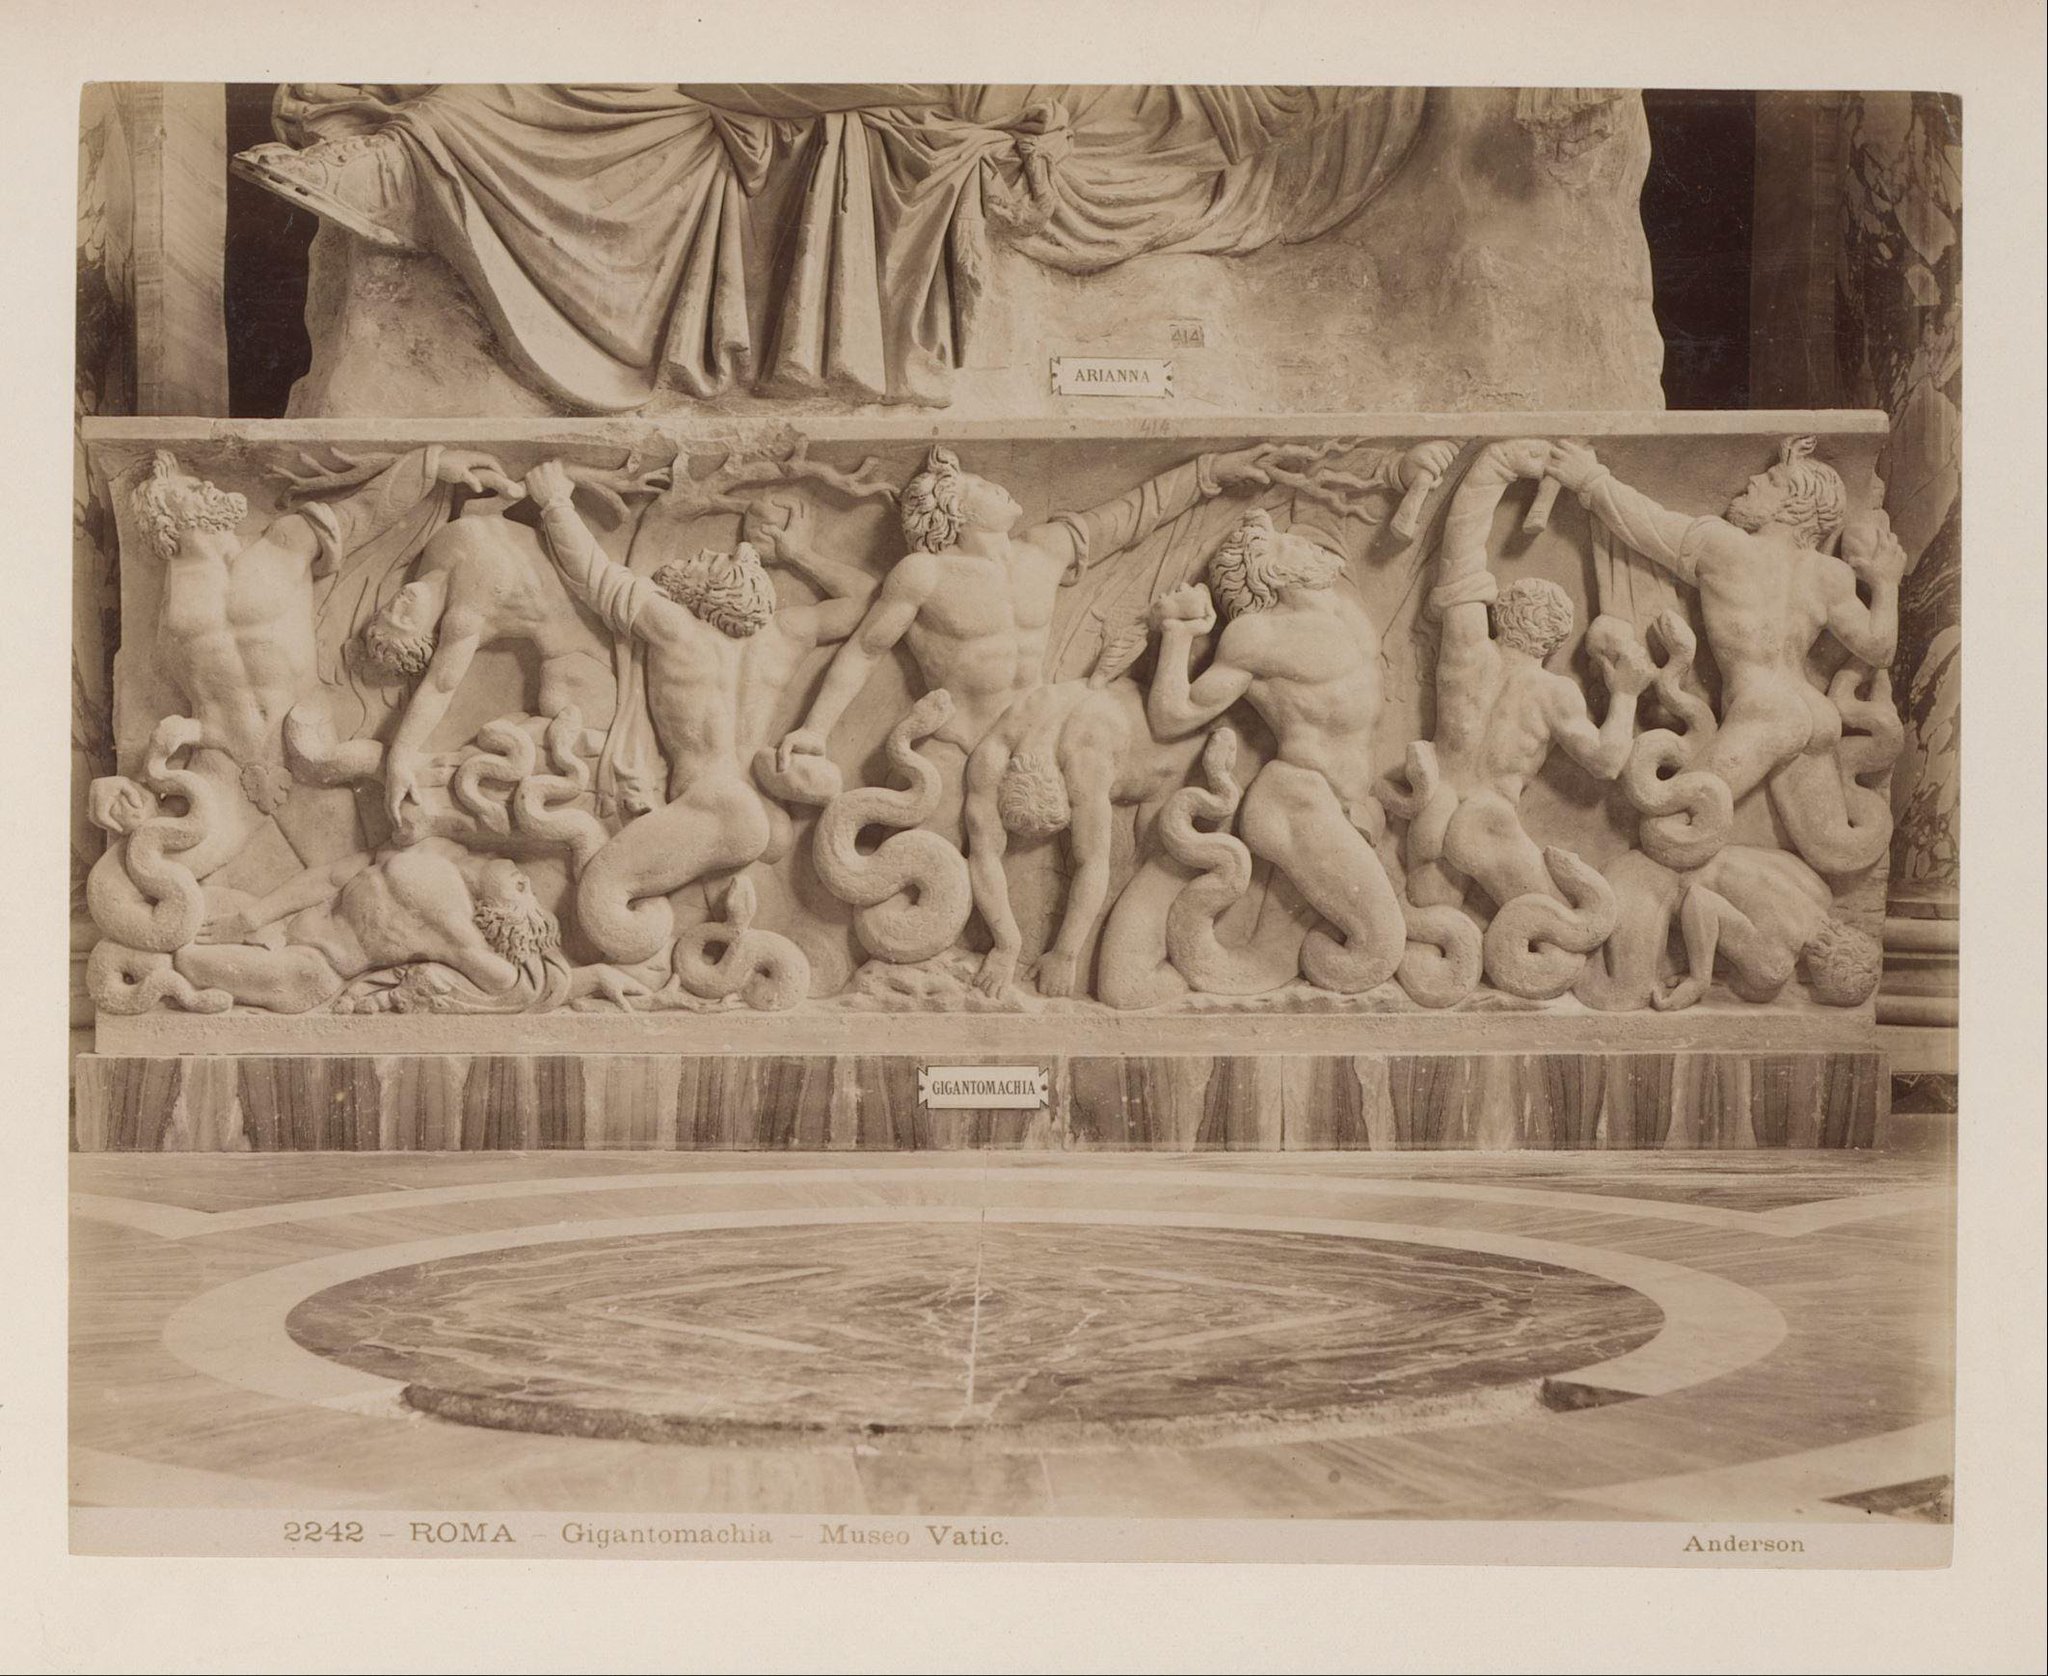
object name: photograph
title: Gigantomachia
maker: james anderson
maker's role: fotograaf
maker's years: 1813-1877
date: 1857-1875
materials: paper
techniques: albumen print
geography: vatican museums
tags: battle of the giants against the gods: gigantomachy, piece of sculpture, reproduction of a piece of sculpture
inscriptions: inscription: ‘2242 - ROMA - Gigantomachia - Museo Vatic. Anderson’